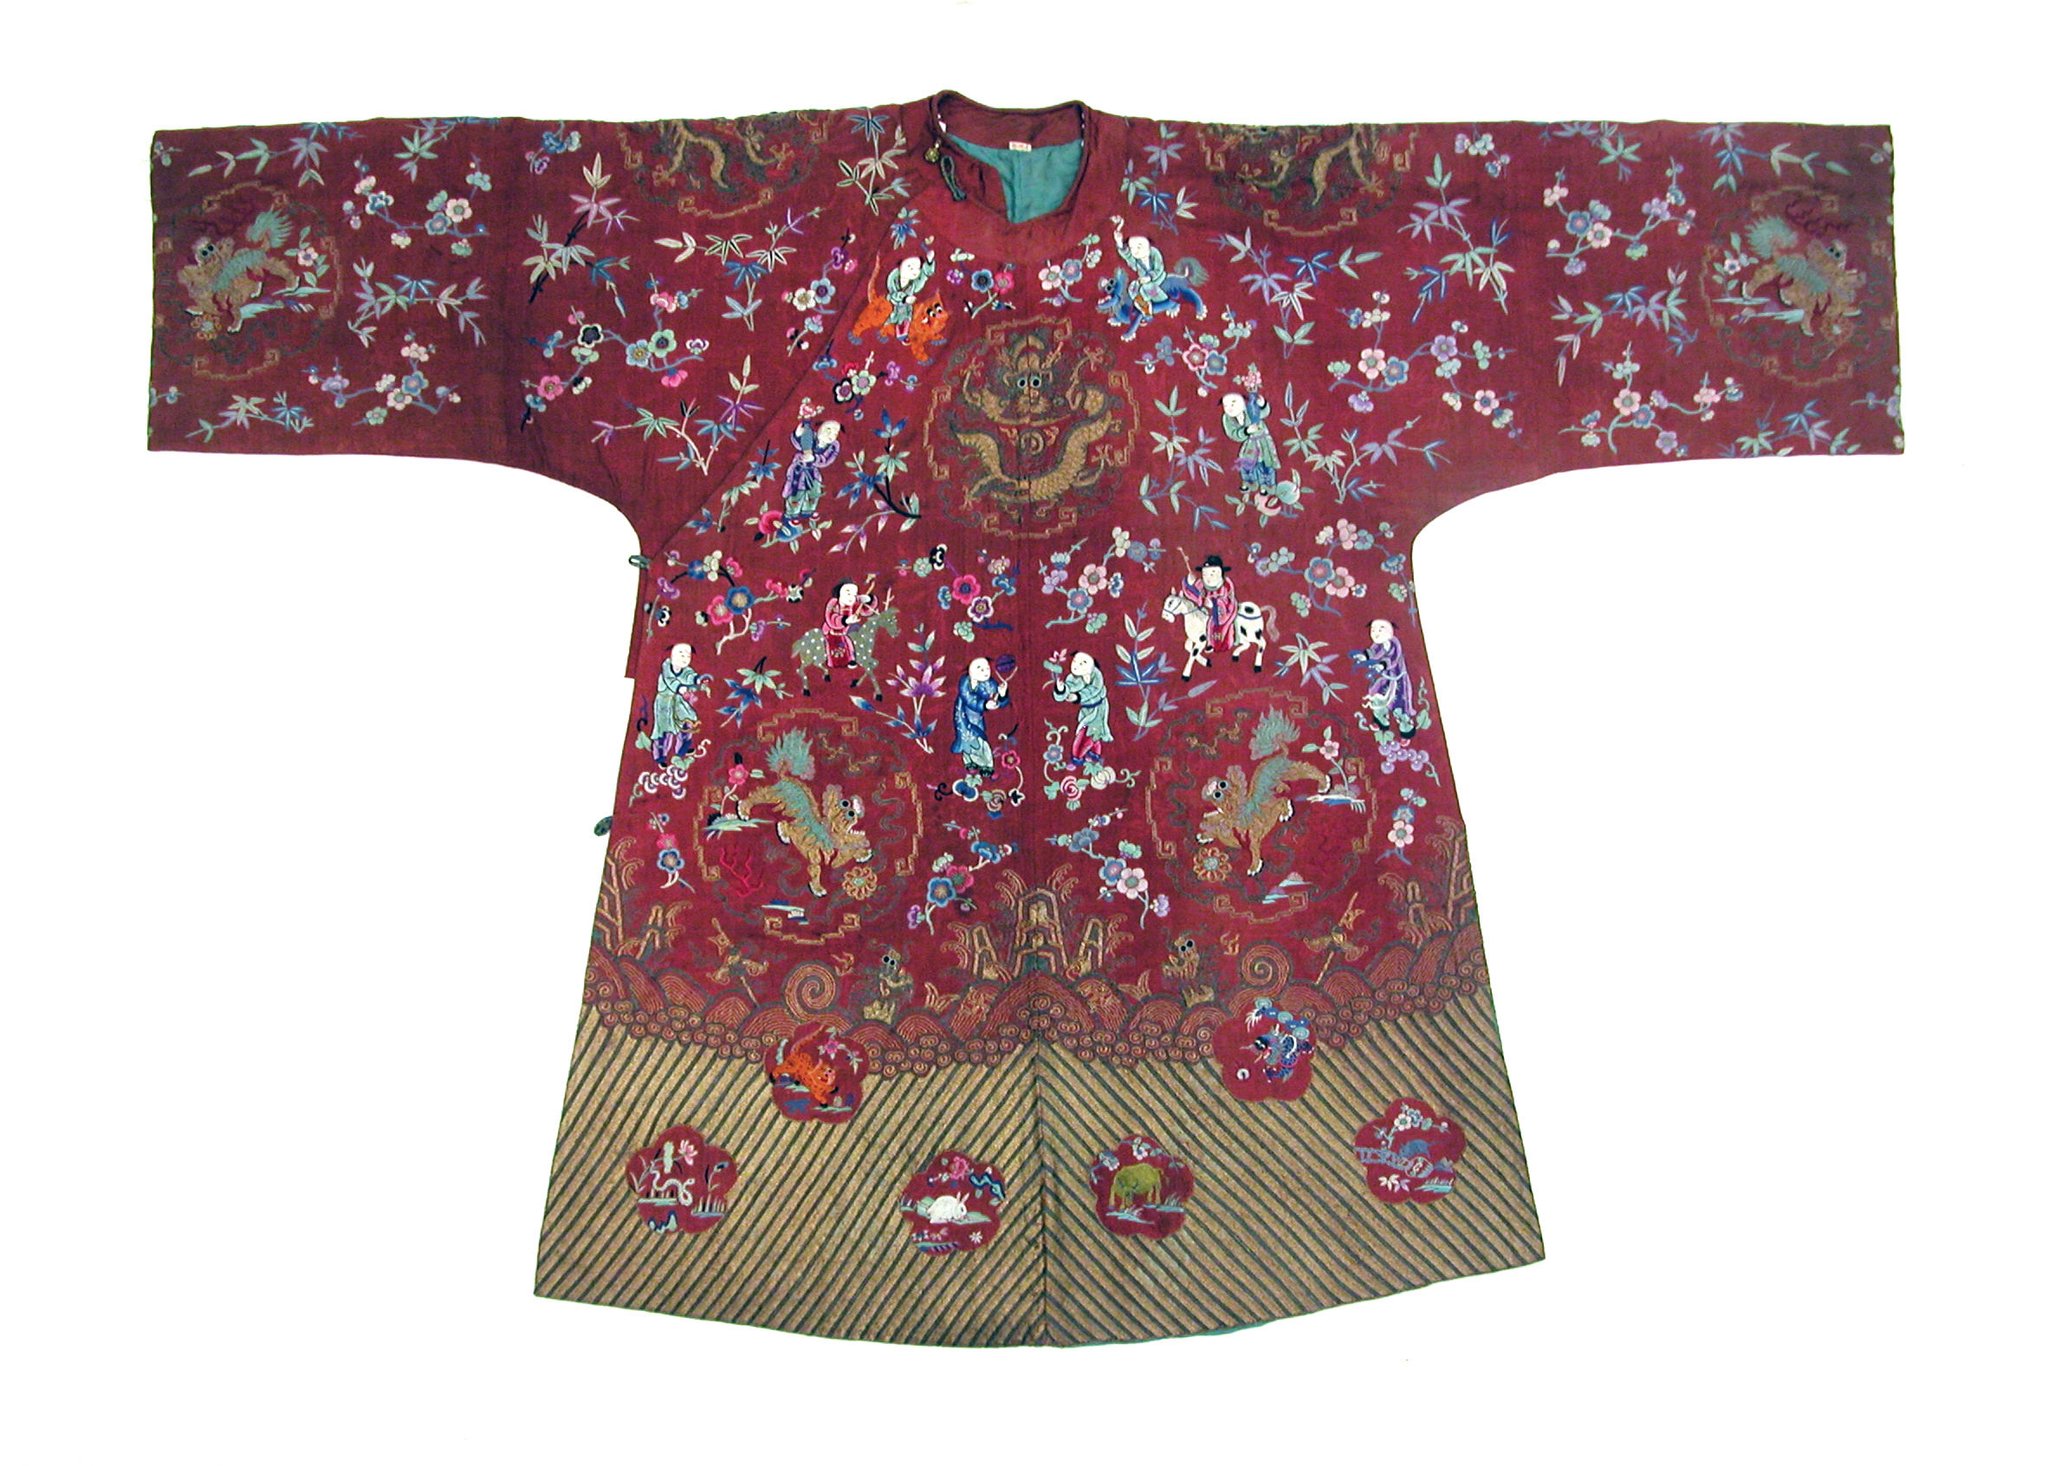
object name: woman's wedding coat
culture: chinese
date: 1801-1900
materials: metal thread, silk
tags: human figures,mythical creatures,flowers